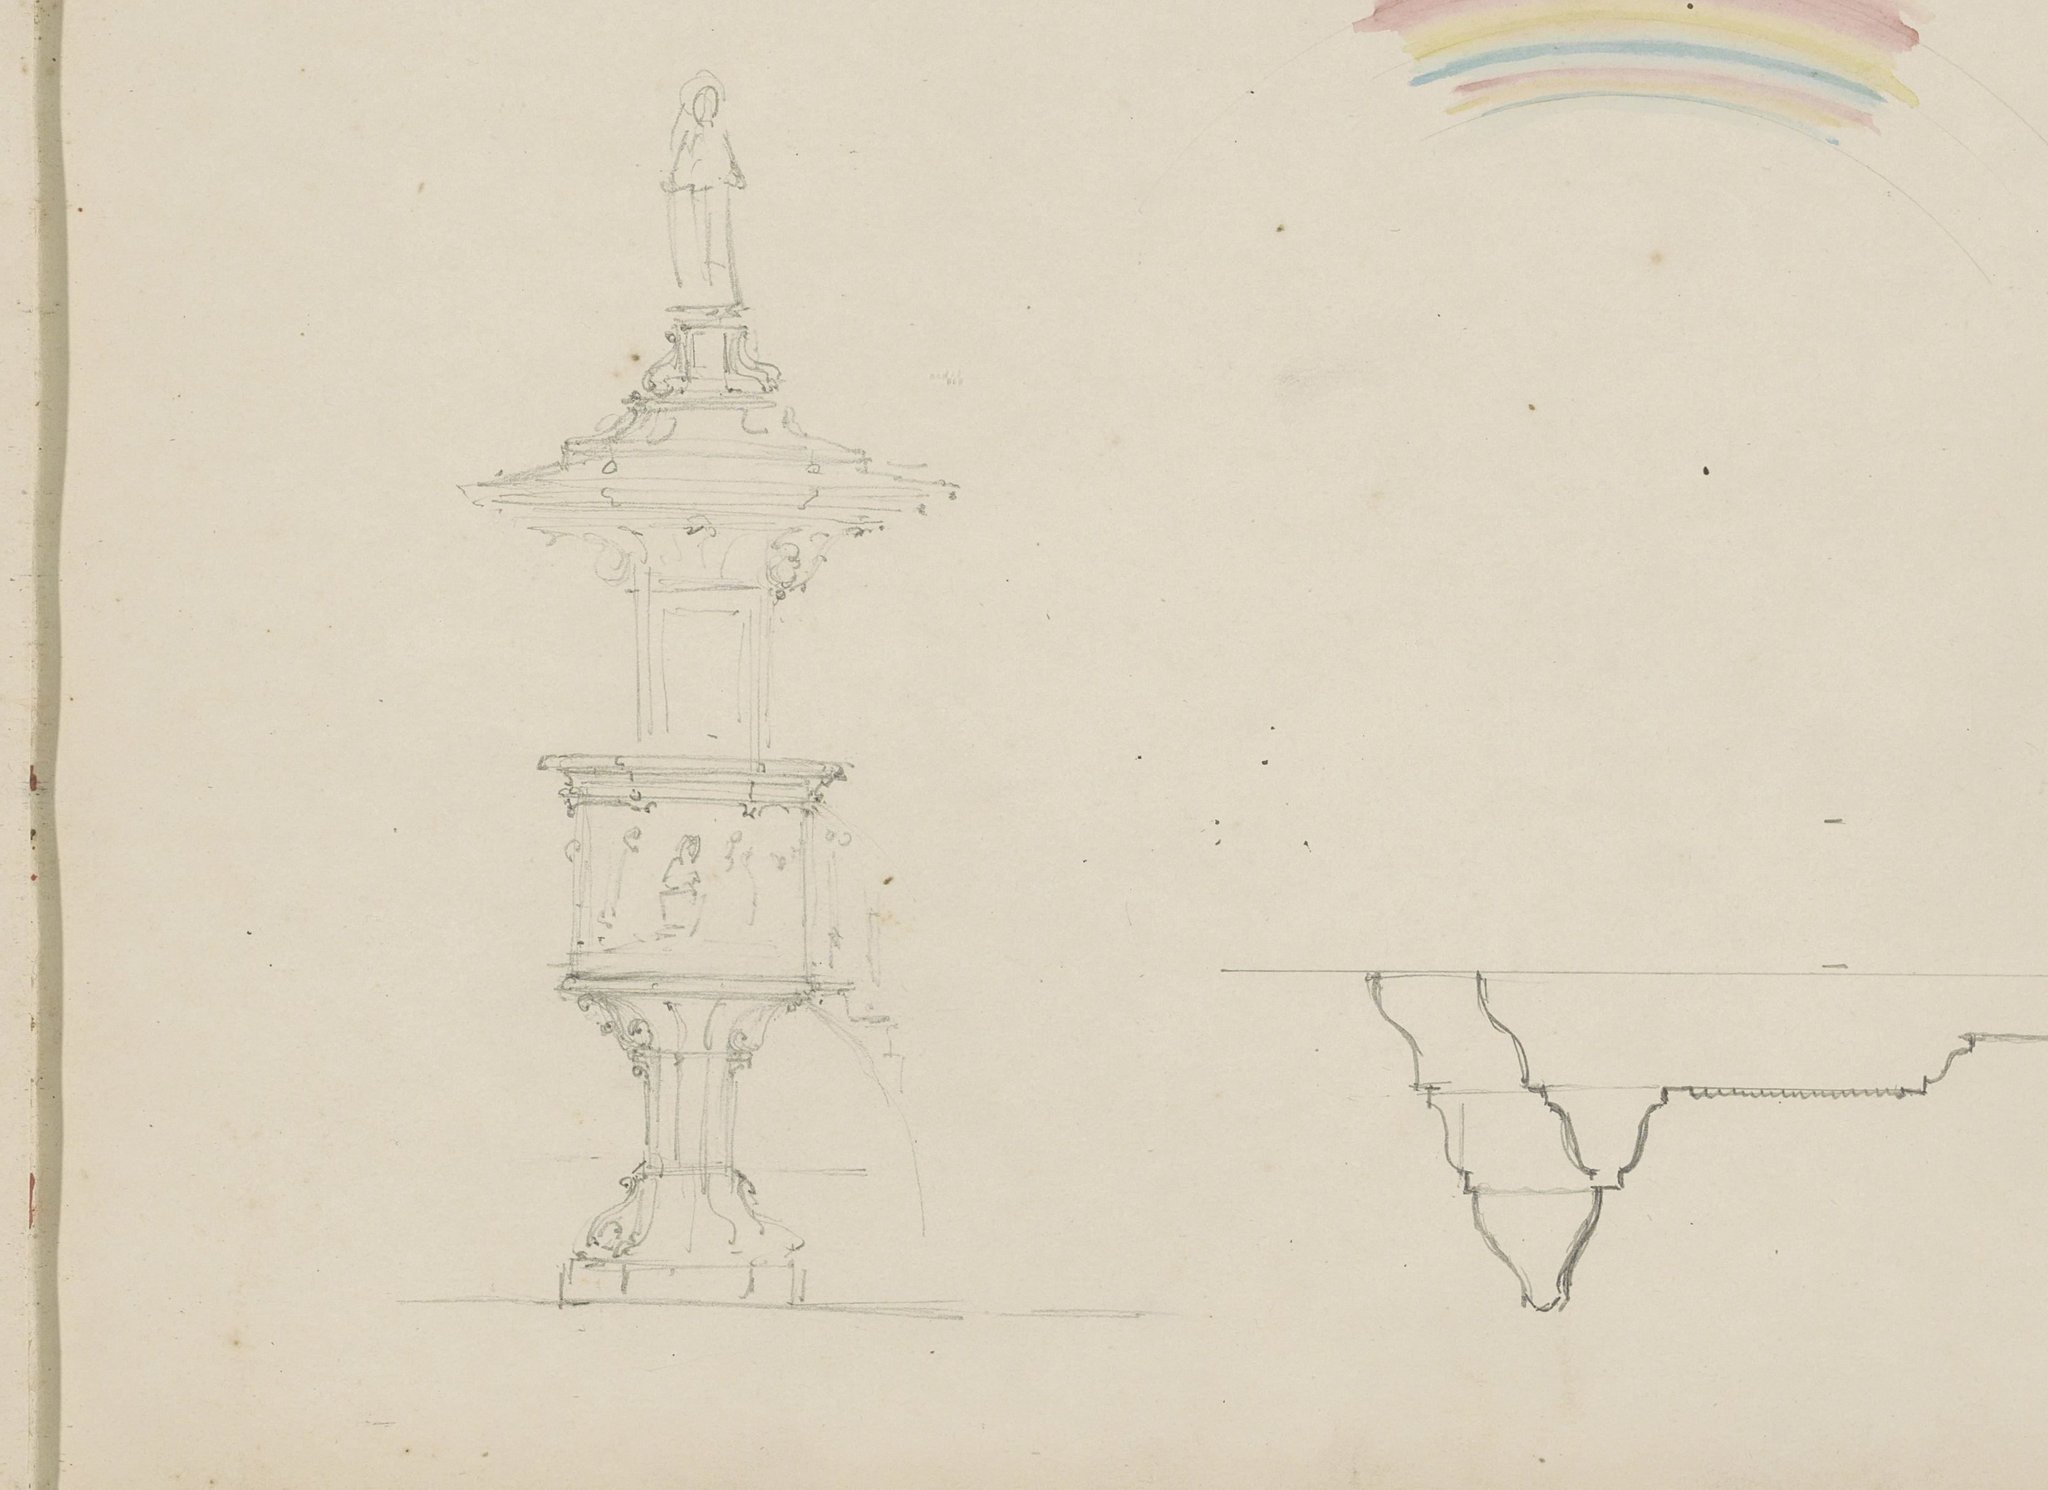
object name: sketchbook leaf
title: Preekstoel en regenboog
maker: pierre joseph hubert cuypers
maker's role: draughtsman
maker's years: 1827-1921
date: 1857-1859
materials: paper, pencil, watercolor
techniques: brush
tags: pulpit, ambo, chancel, rainbow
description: Blad 4 recto uit een schetsboek met 77 bladen.